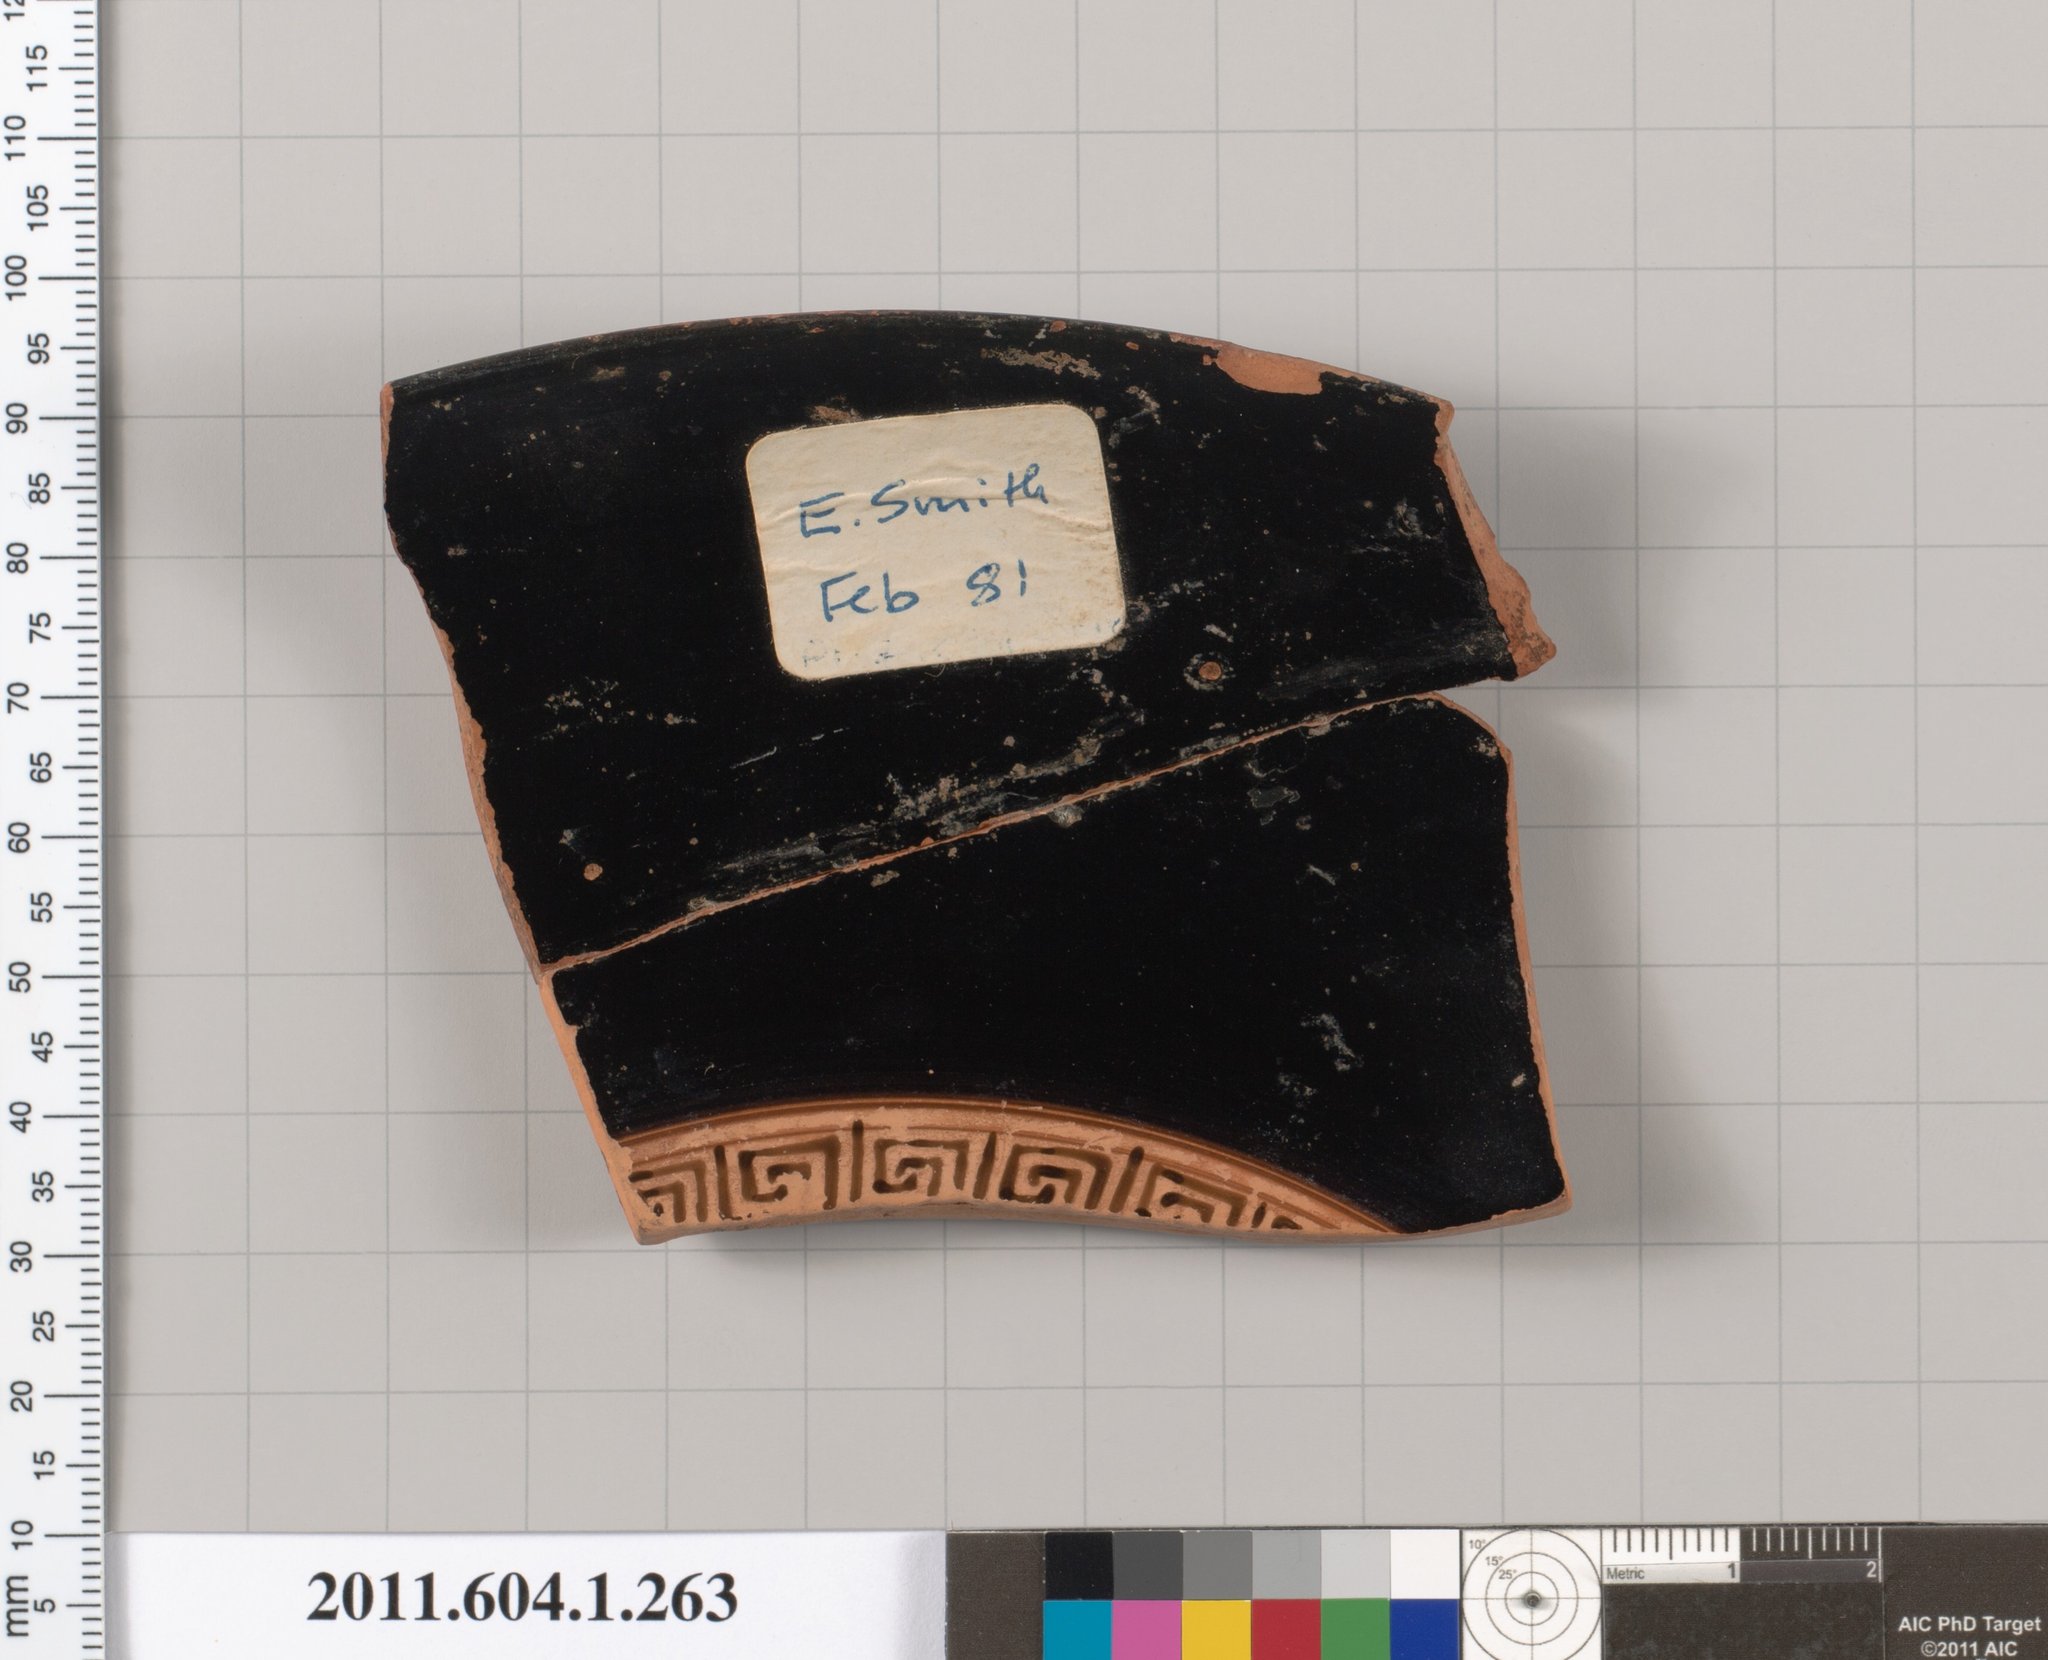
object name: kylix fragment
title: Terracotta rim fragment of a kylix (drinking cup)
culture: greek, attic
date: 467-435 BCE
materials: terracotta